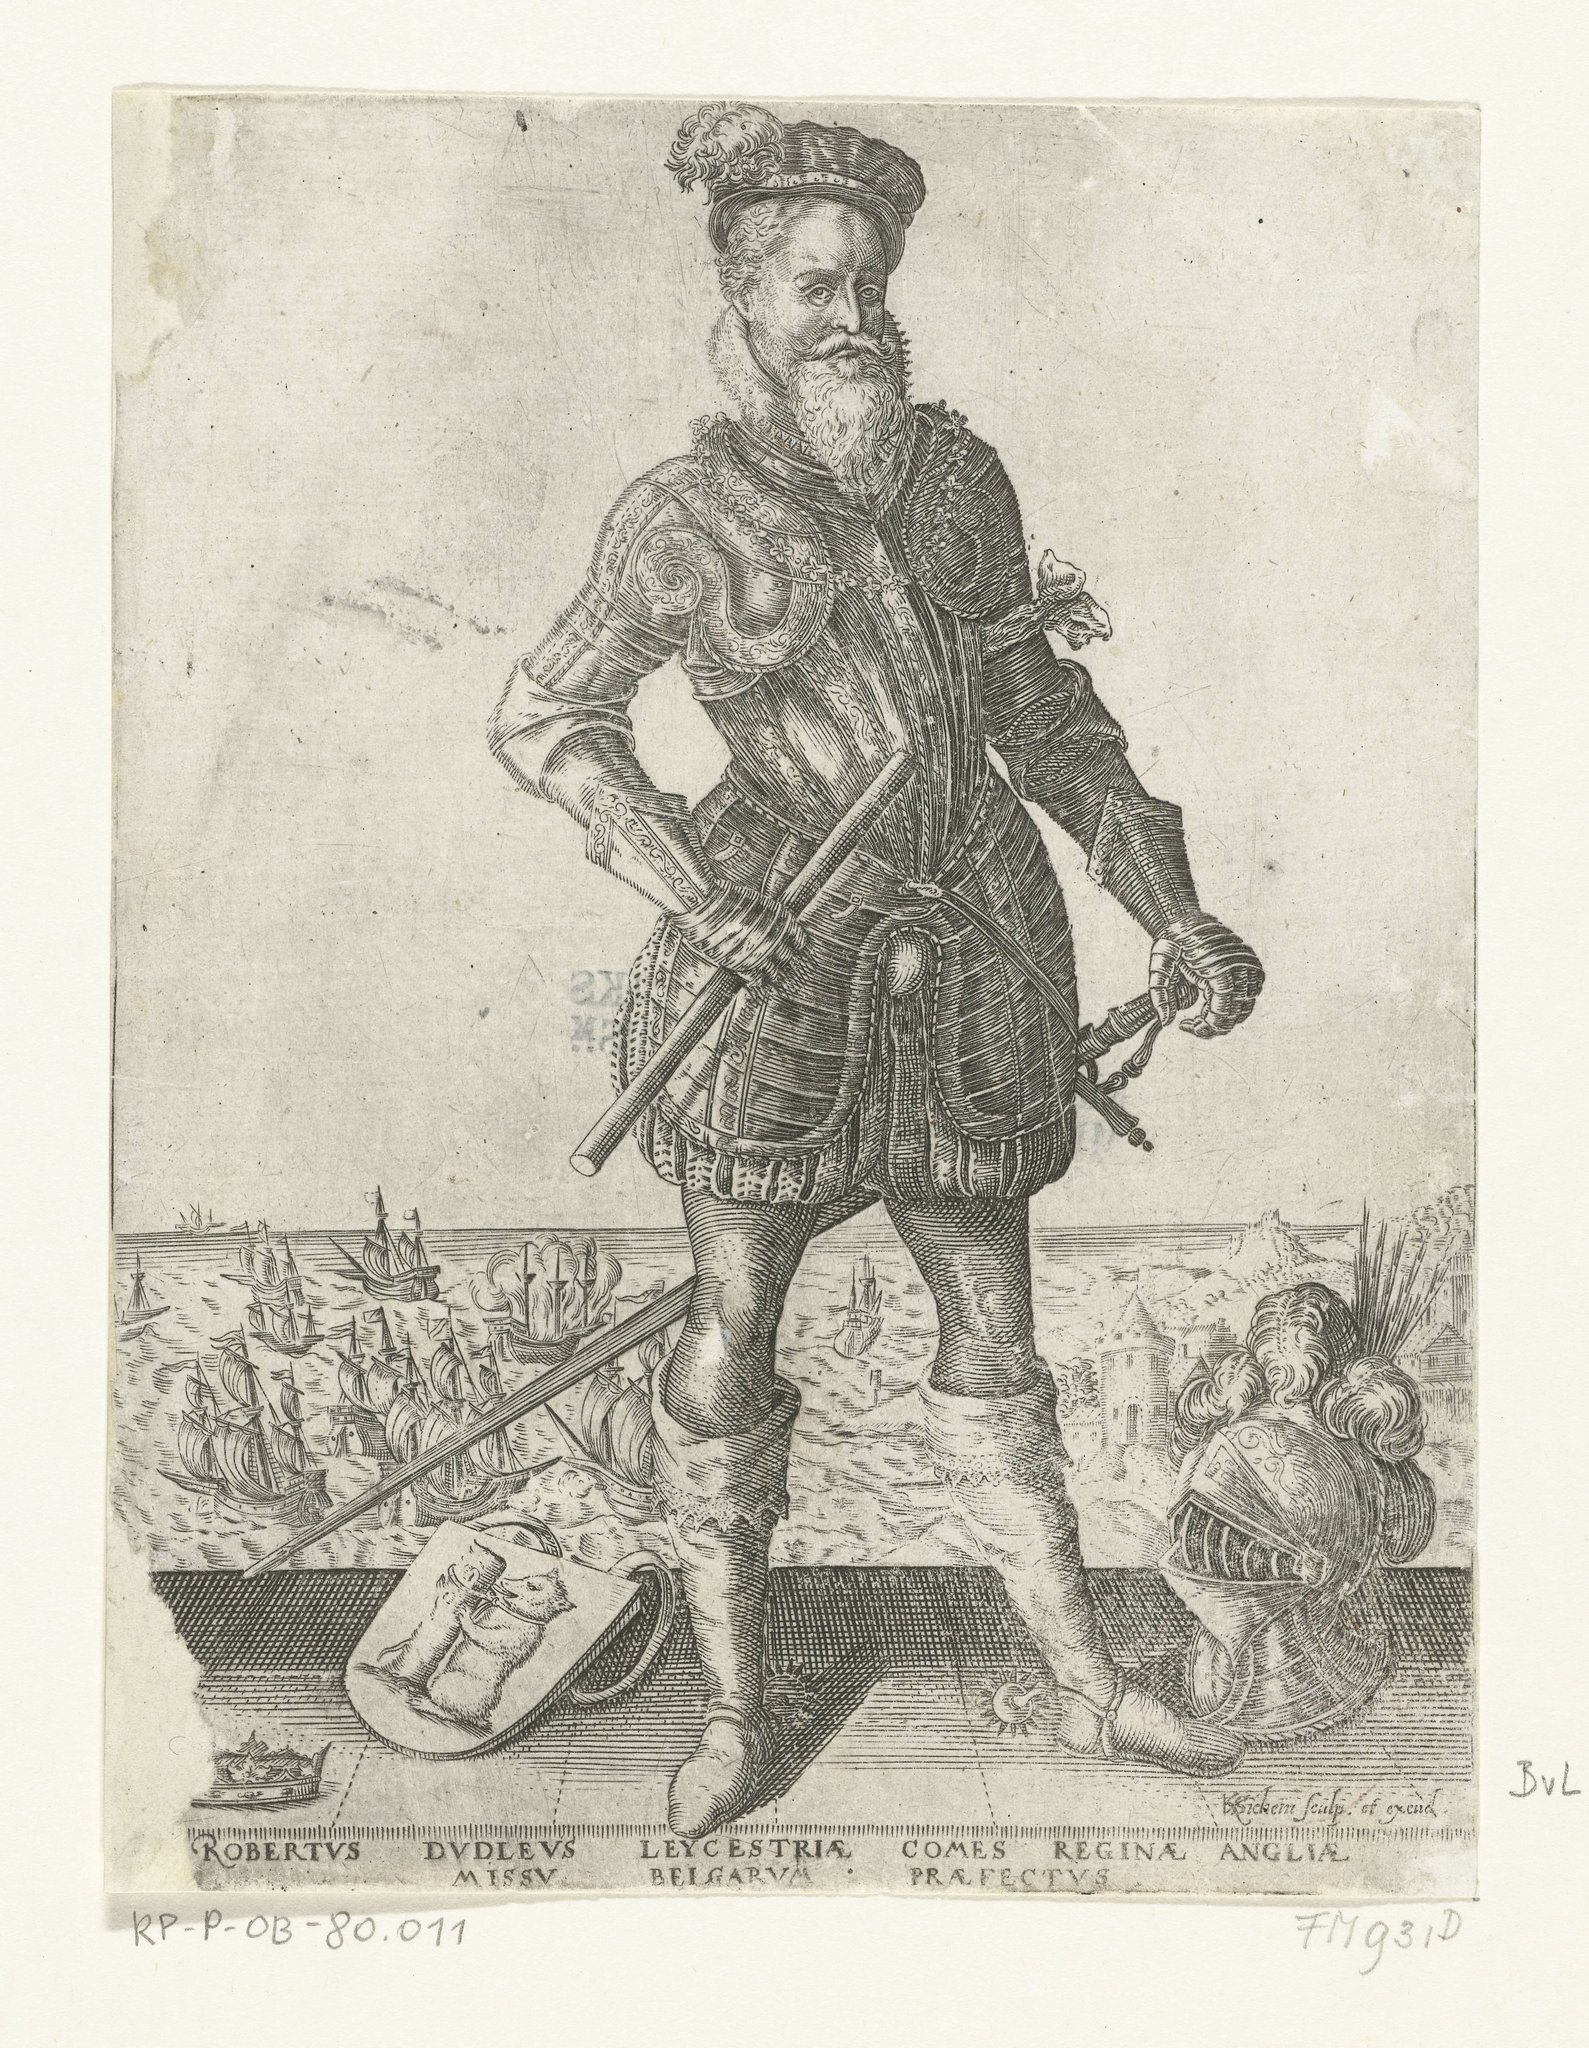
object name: print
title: Portret van Robert Dudley, graaf van Leicester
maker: karel van sichem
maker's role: print maker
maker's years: 1575-1604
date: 1601-1604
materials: paper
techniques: engraving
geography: northern netherlands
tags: robert dudley (1st earl of leicester)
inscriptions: collector's mark: Lugt 240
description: Portret van Robert Dudley, graaf van Leicester. Staande, ten voeten uit, op de grond een kroon, familiewapen en helm. Op de achtergrond schepen voor de kust.